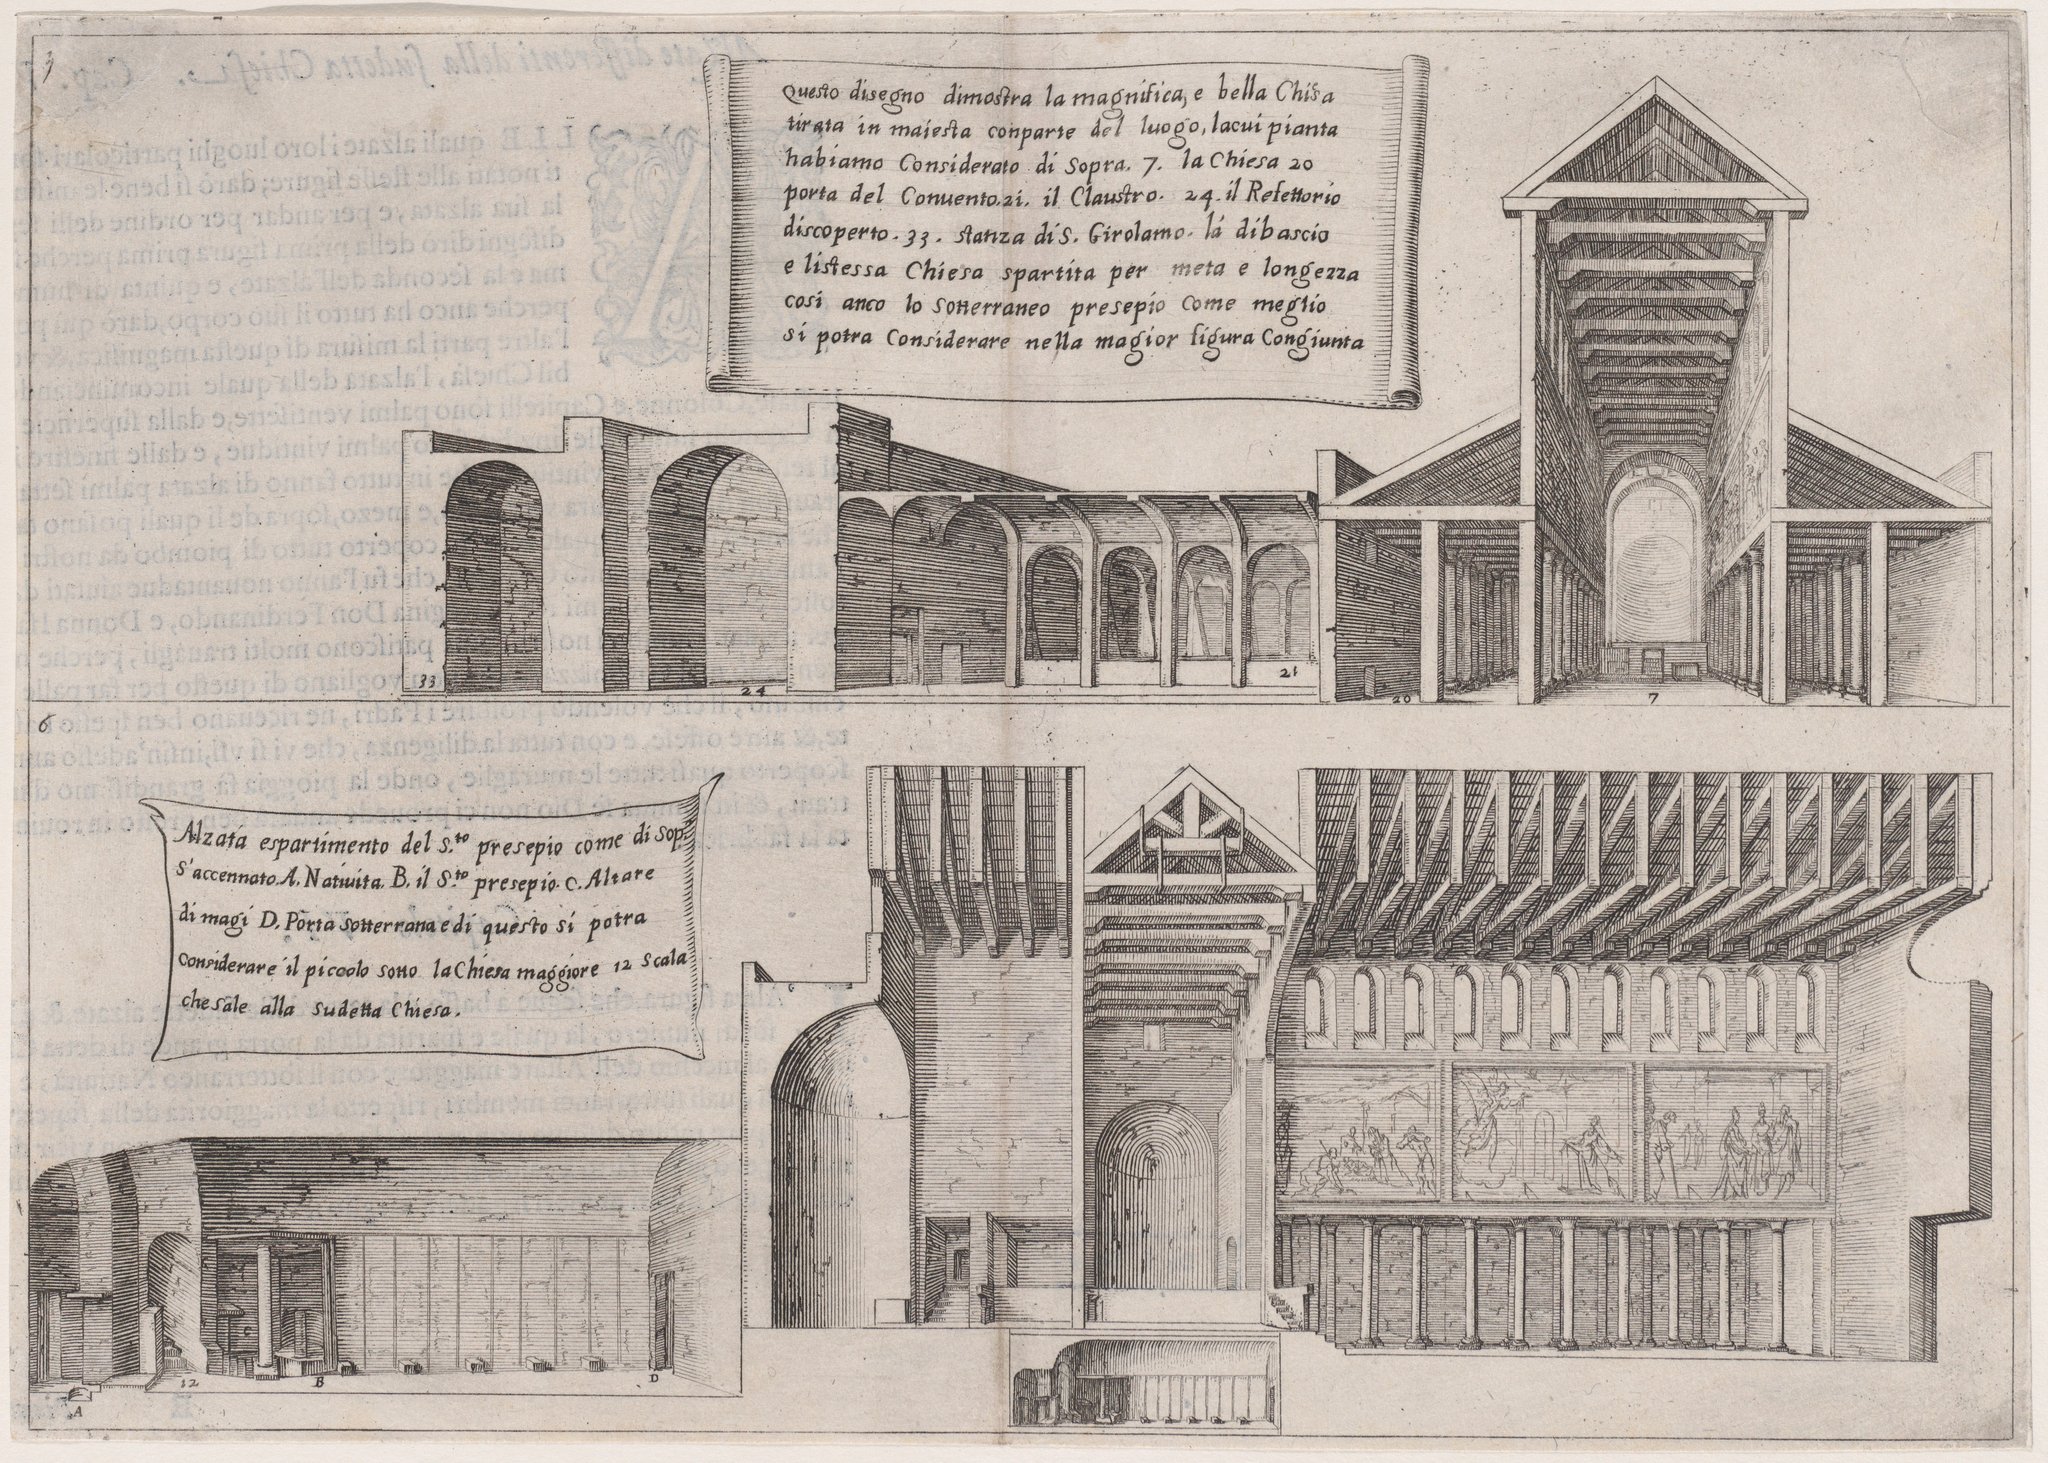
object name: print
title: Plate 5, from "Trattato delle Piante & Immagini de Sacri Edifizi di Terra Santa" (Treatise of the Plans & Images of the Sacred Buildings of the Holy Land)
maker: jacques callot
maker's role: artist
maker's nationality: french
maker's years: 1592-1635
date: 1620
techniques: engraving, etching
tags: architecture,buildings